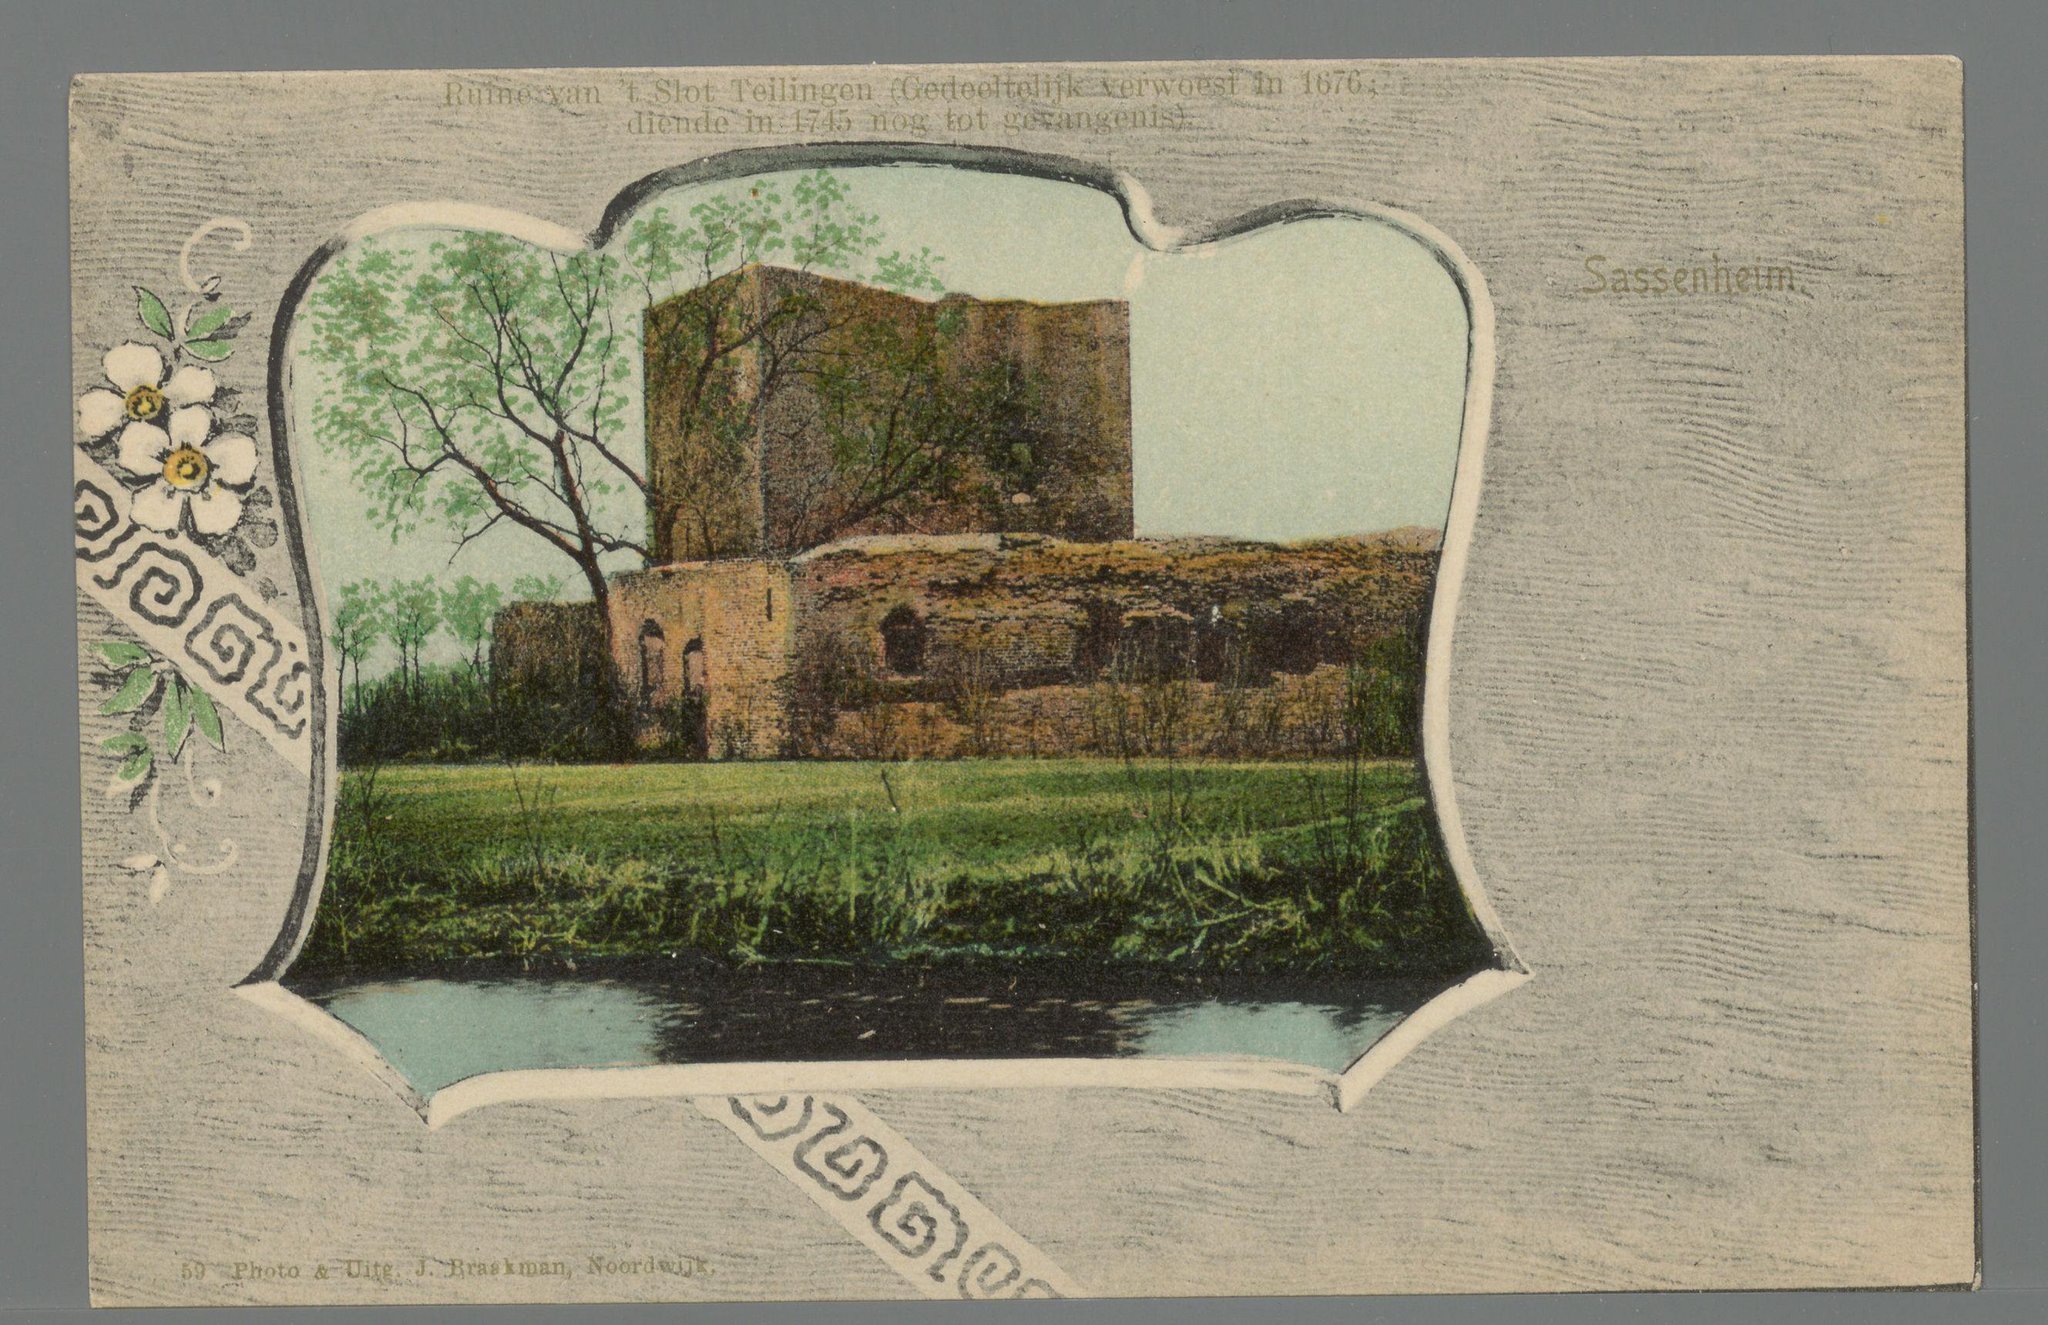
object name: photomechanical print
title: Ruine van 't Slot Teilingen (gedeeltelijk verwoest in 1676; diende in 1745 nog tot gevangenis). Sassenheim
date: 1892-1905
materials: cardboard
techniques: photograph, lithograph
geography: noordwijk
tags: ruin of a dwelling, house, castle, etc.